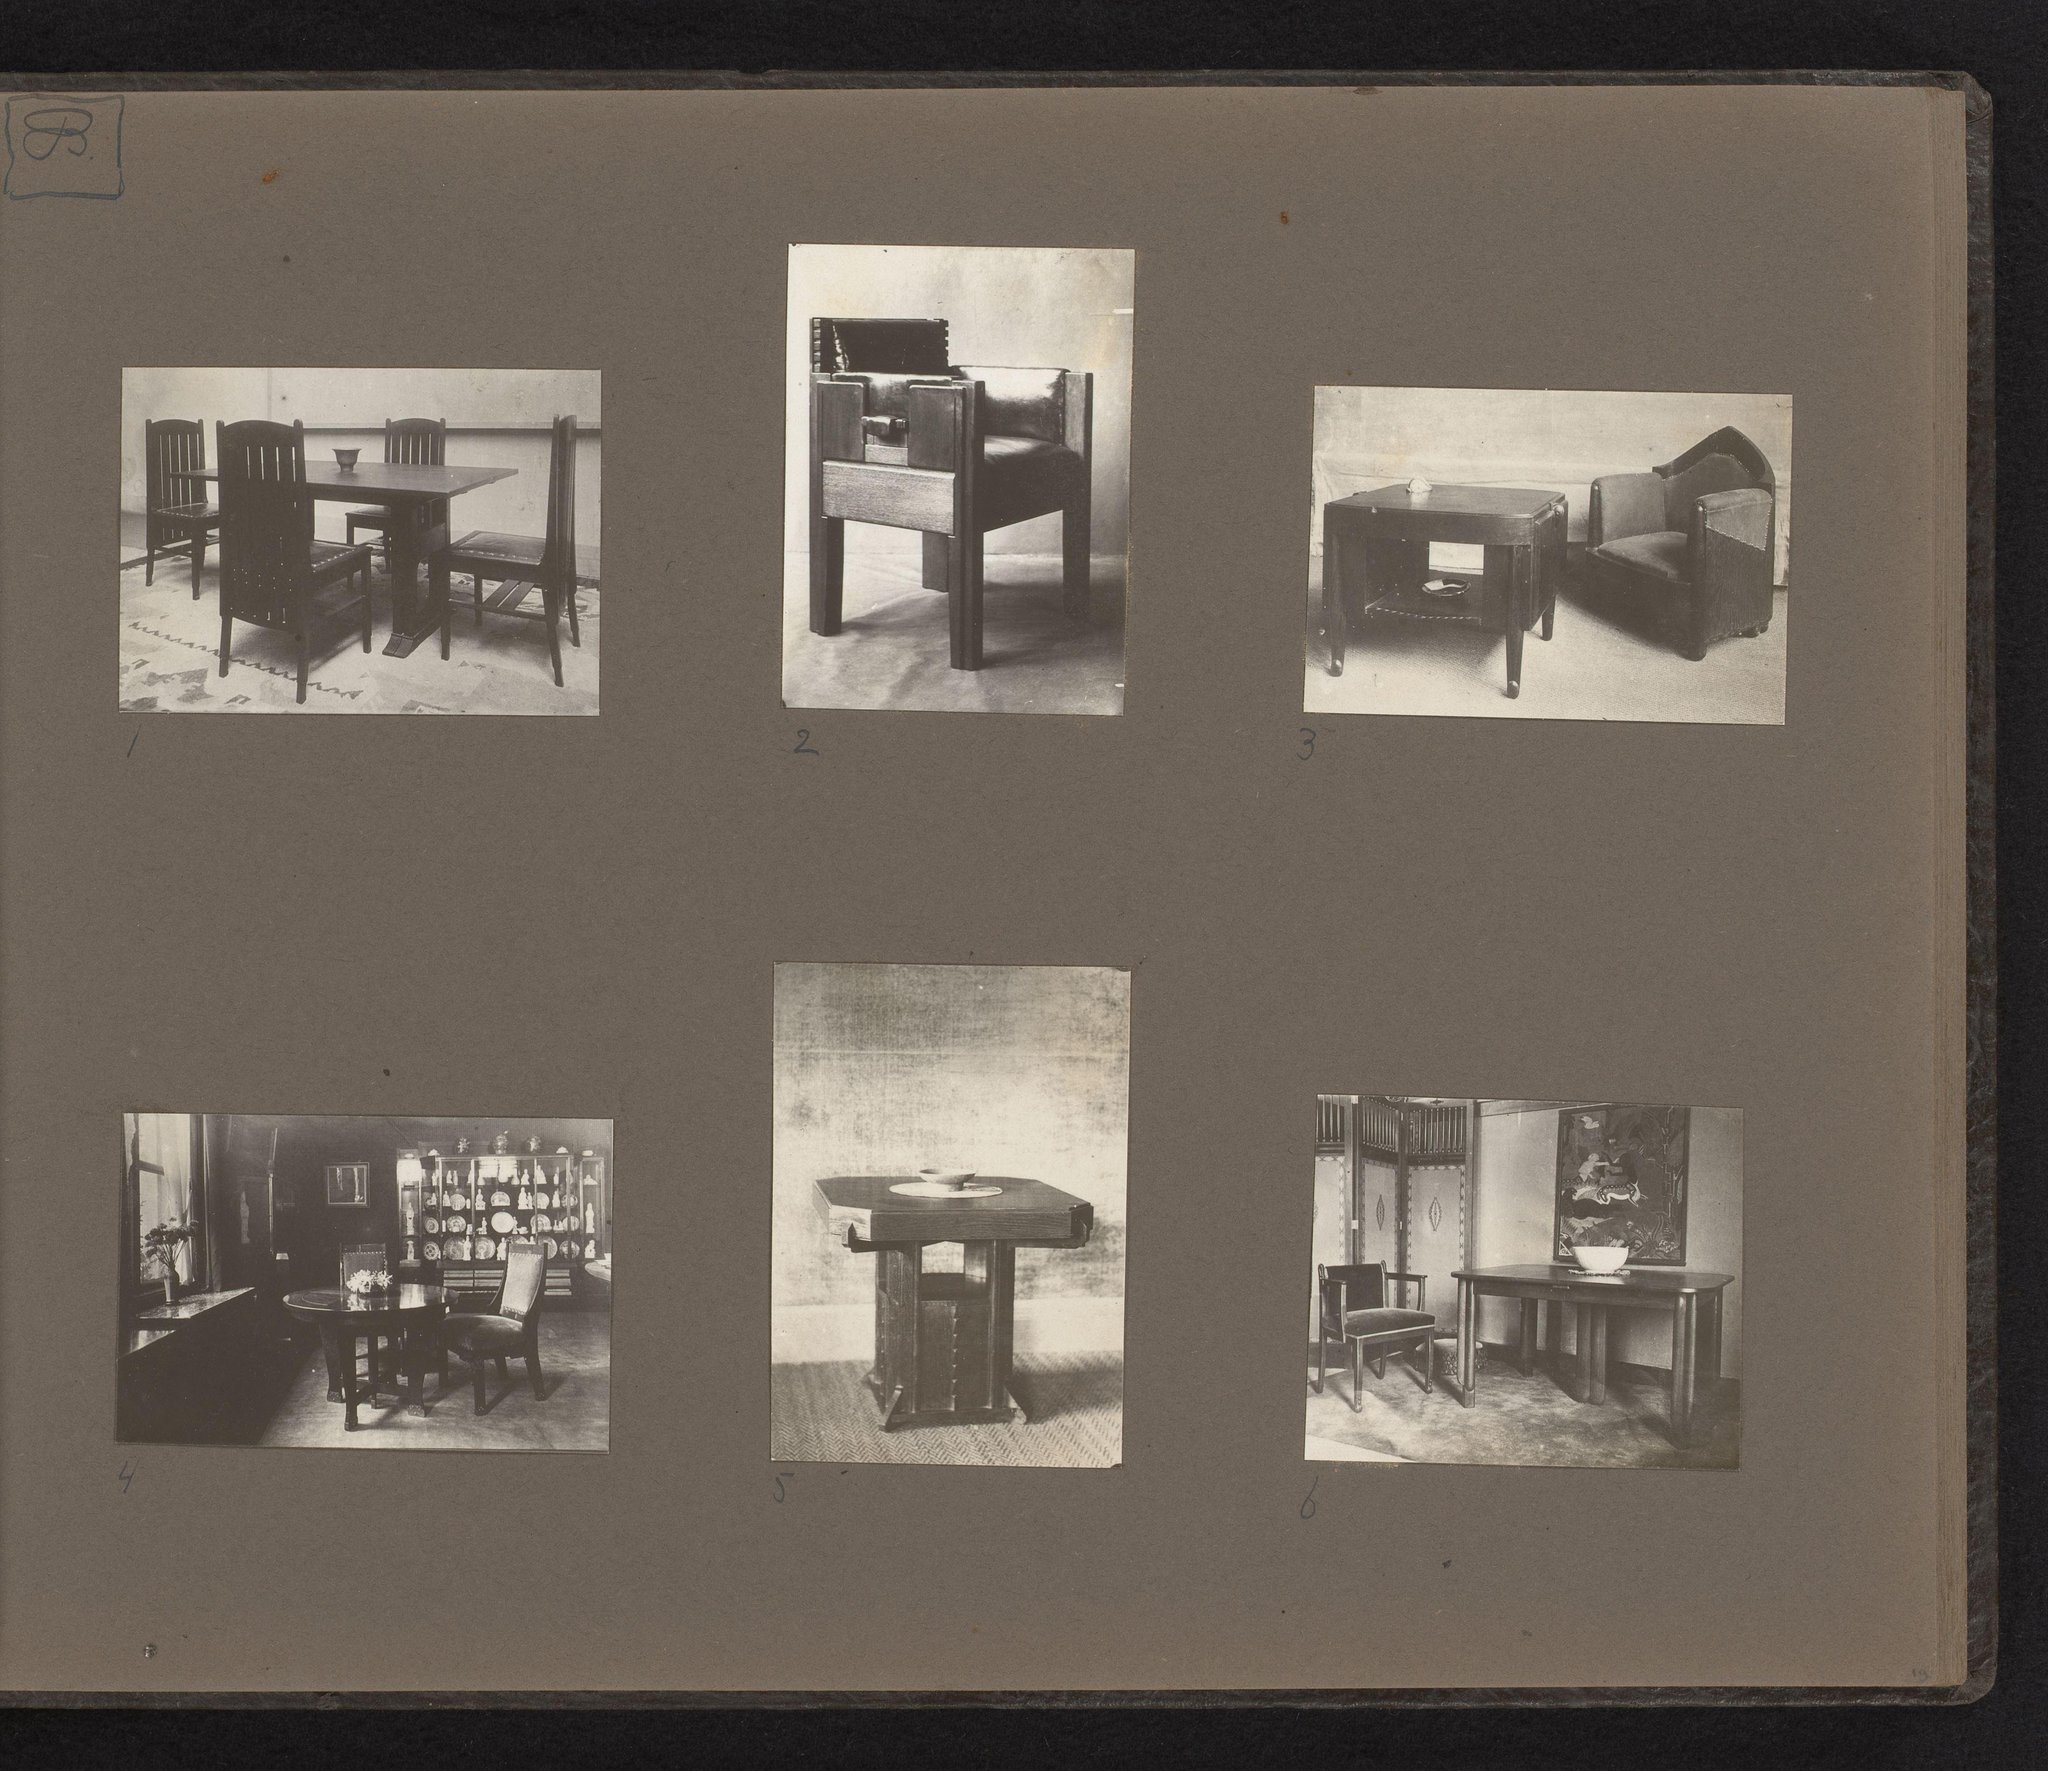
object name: album leaf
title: Houten meubels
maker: Anonymous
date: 1920-1940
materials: paper, photographic support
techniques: gelatin silver print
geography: netherlands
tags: chair (+ wood and other phytogenic material), table (+ wood and other phytogenic material), communal rooms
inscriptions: annotation: ‘B.’, number: ‘1 - 2 -3/ 4 - 5 - 6’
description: Zes foto's van stoelen en tafels van hout, waarvan twee foto's met een interieur. Deze foto's maken deel uit van een album.